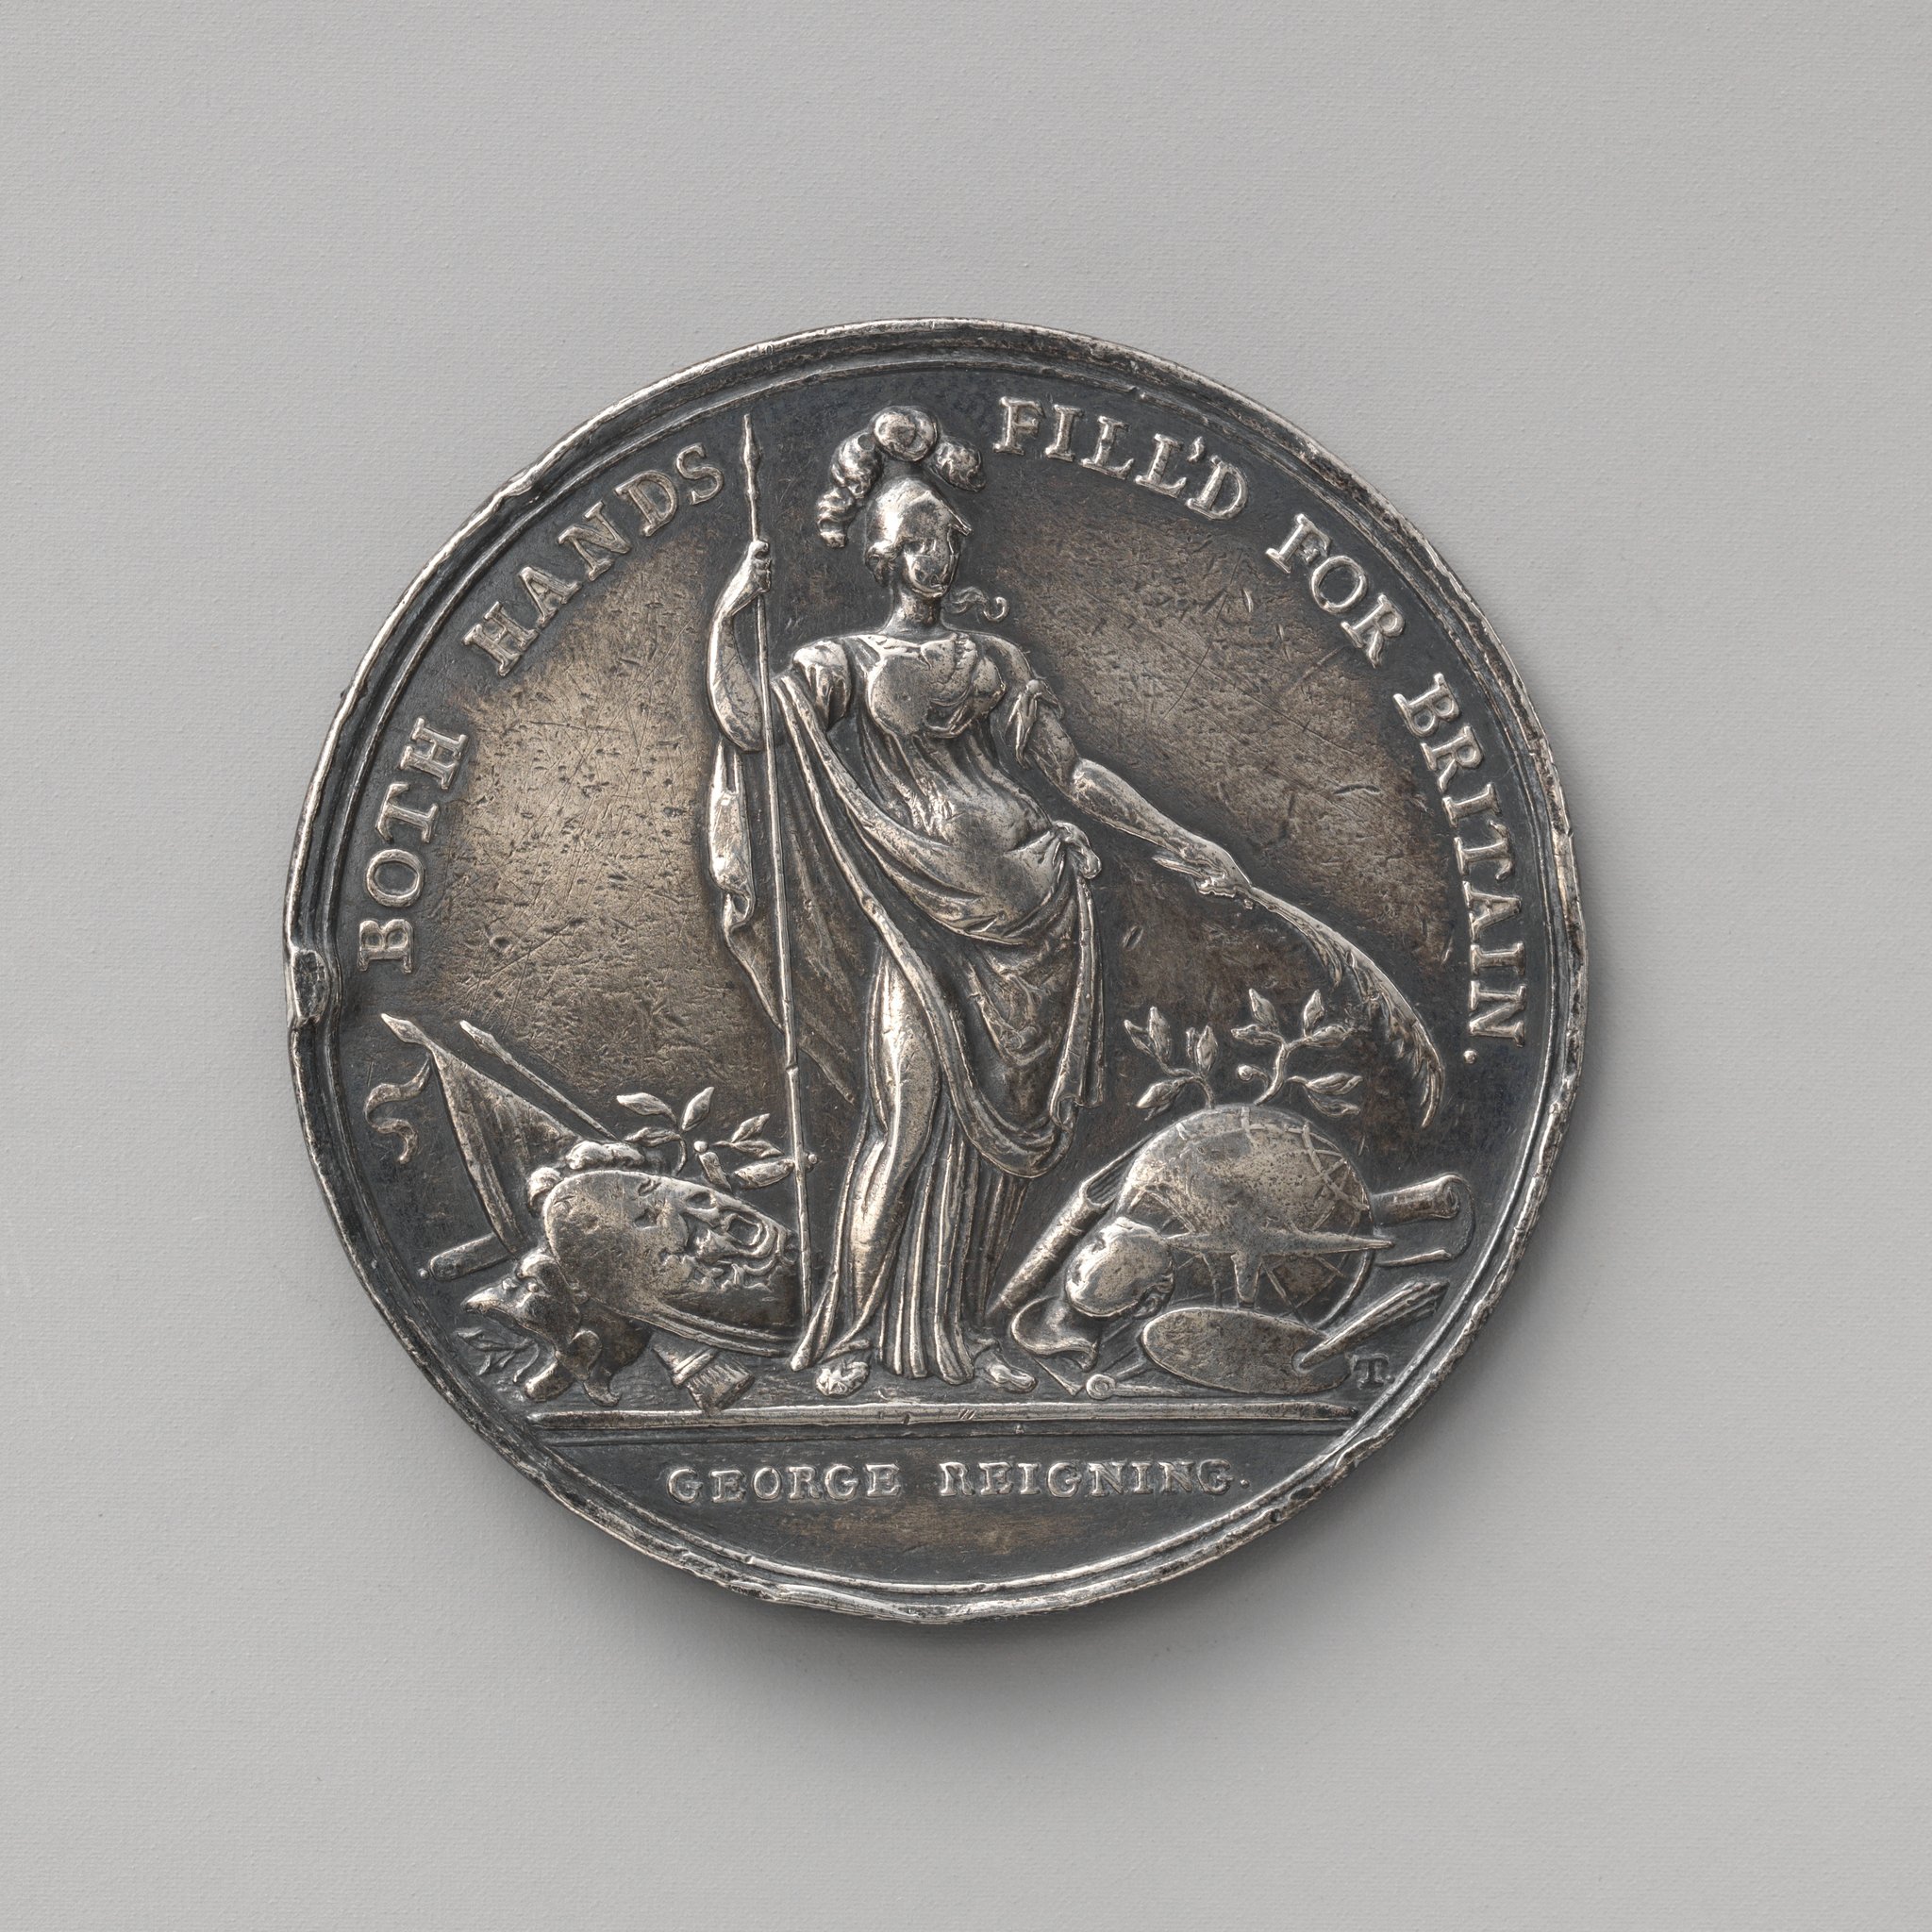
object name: medal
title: Jernegan's Lottery Medal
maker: john sigismund tanner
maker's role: artist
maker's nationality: british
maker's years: 1728-1775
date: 1736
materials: silver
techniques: struck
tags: women,plants